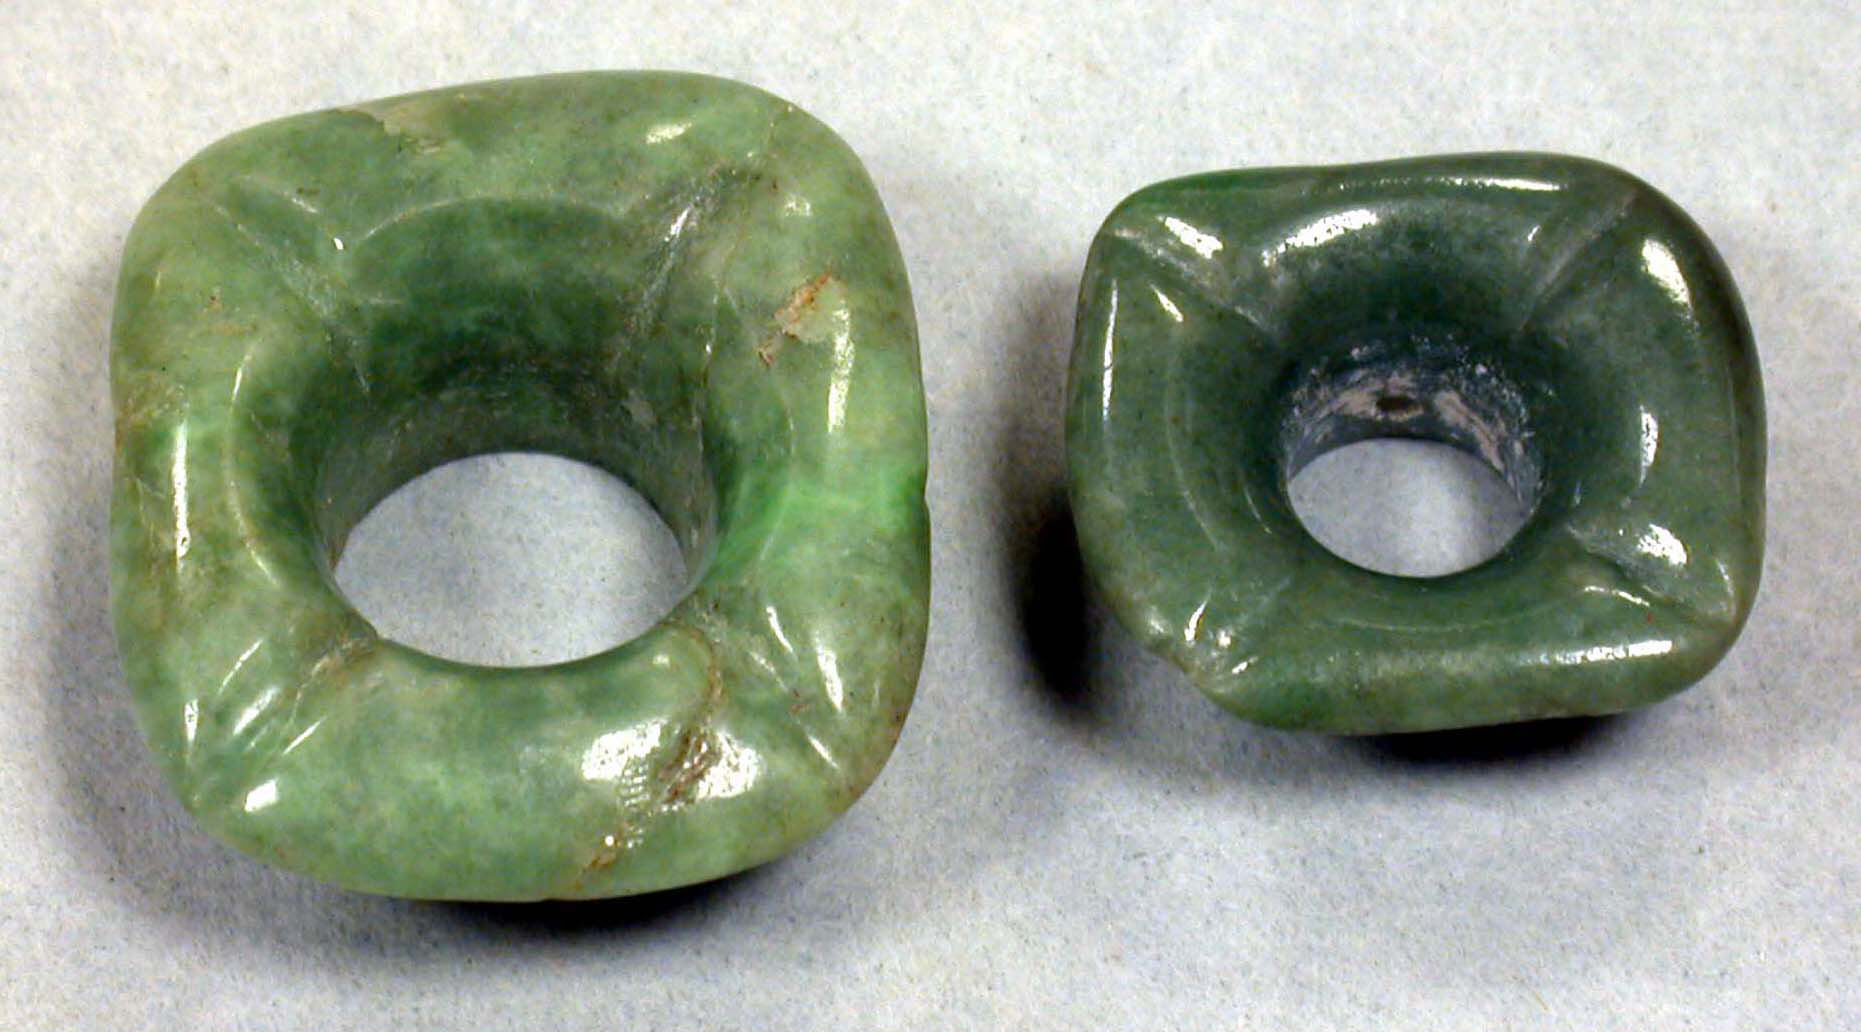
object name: earflare set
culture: maya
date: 201-900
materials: jade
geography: mexico